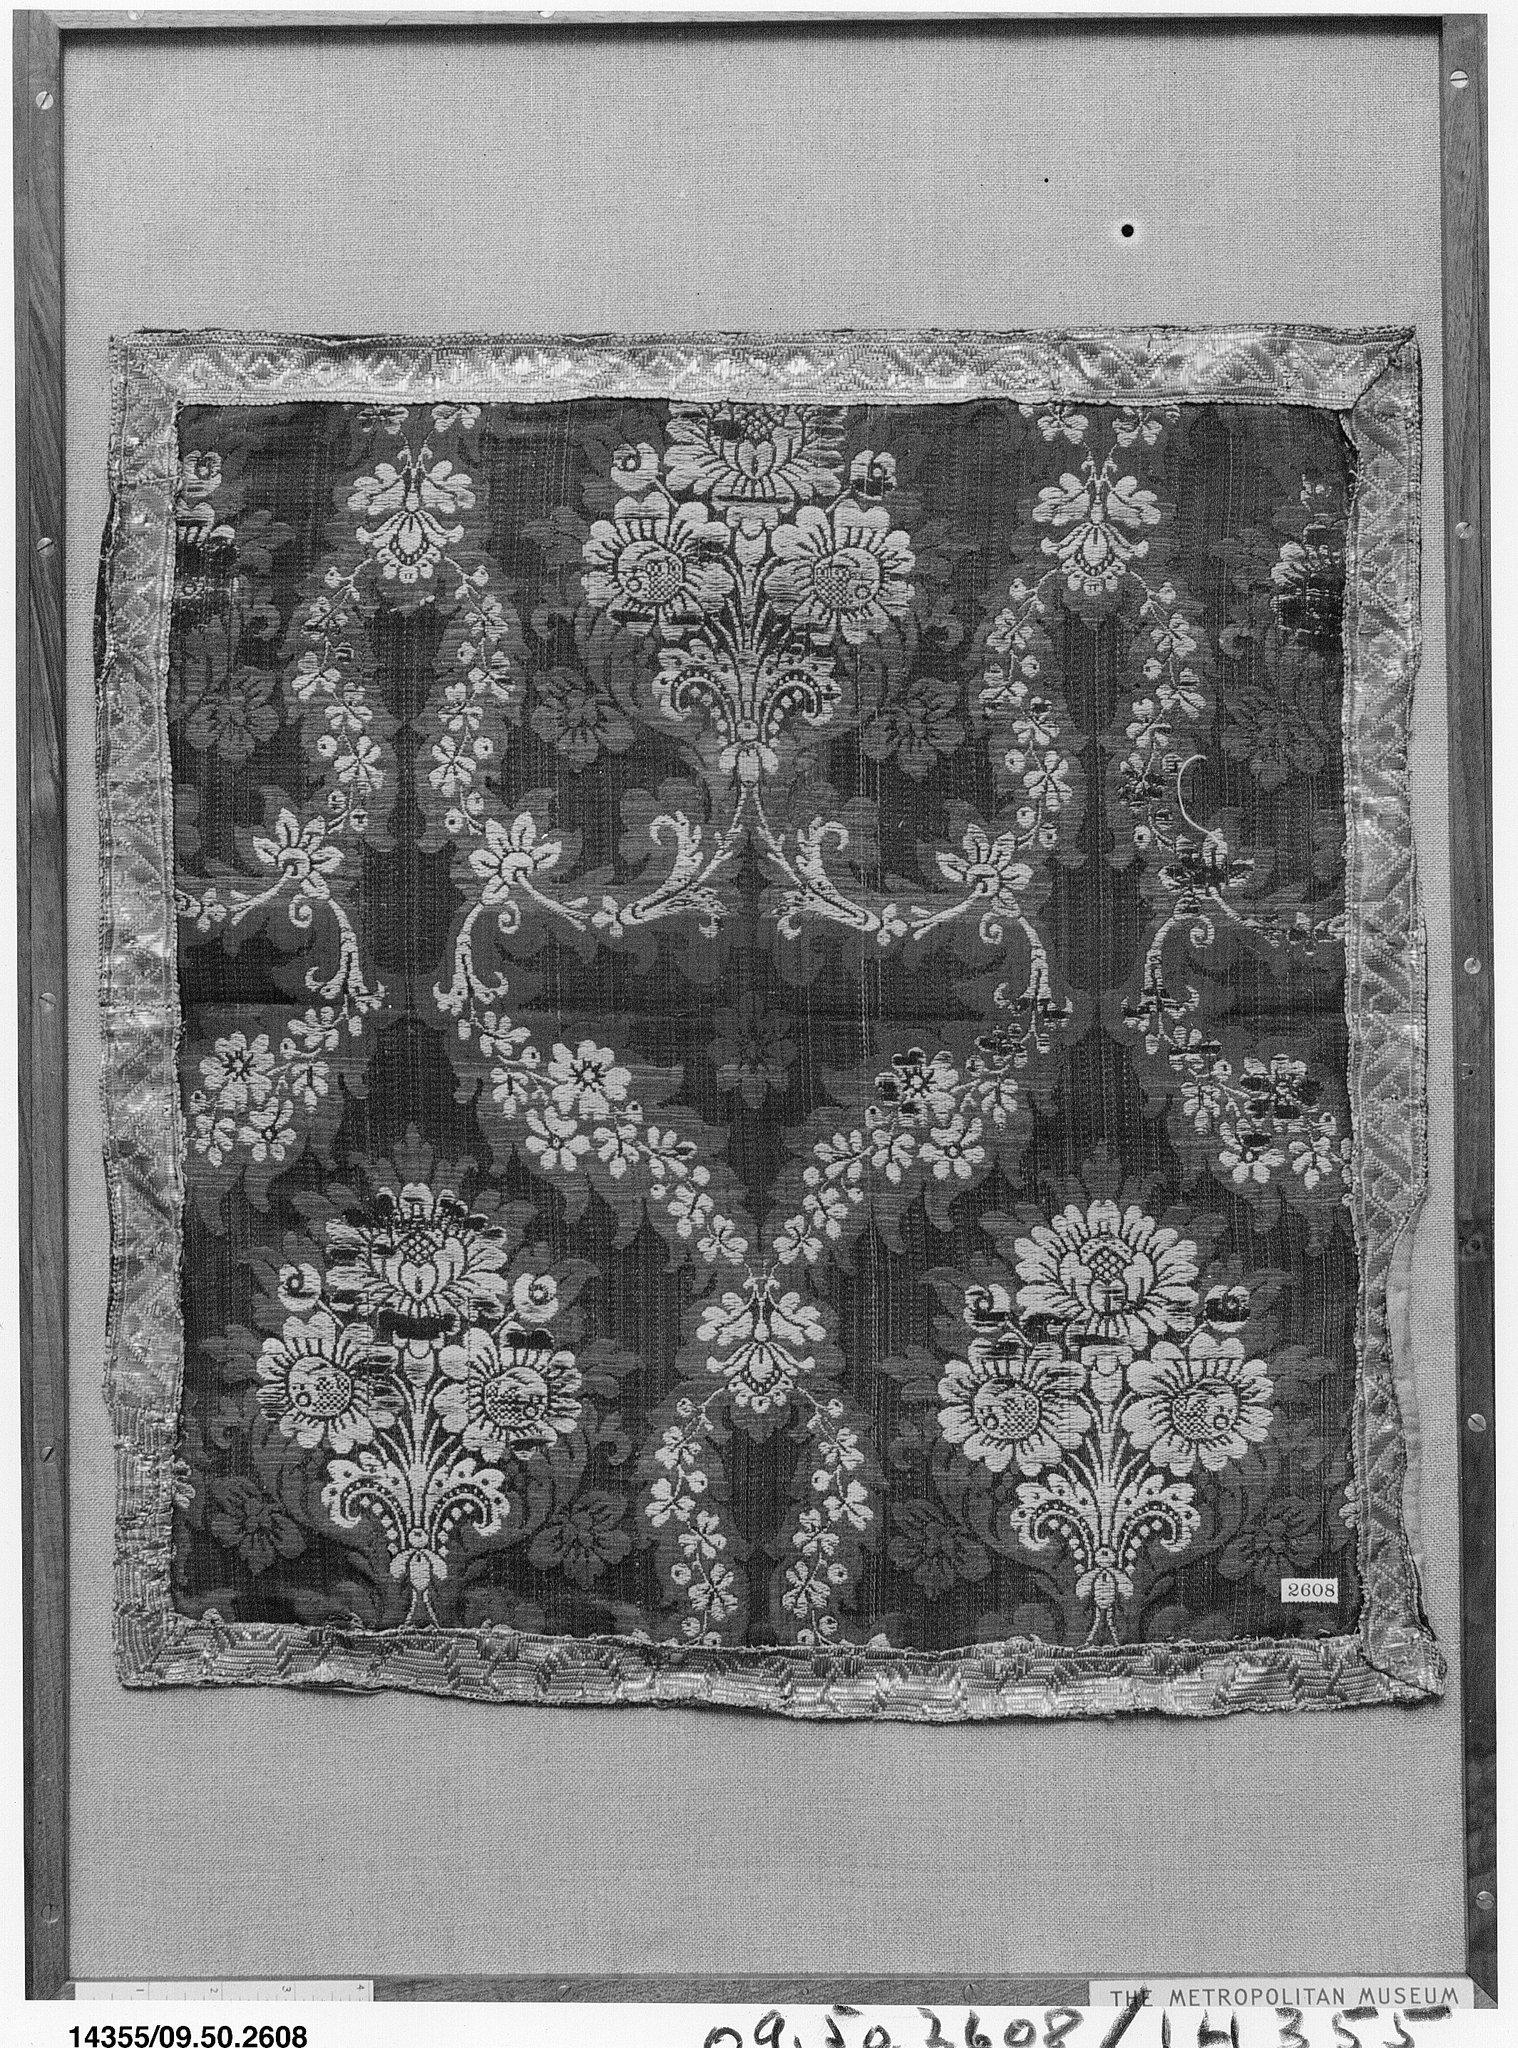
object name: piece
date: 1767-1800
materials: silk